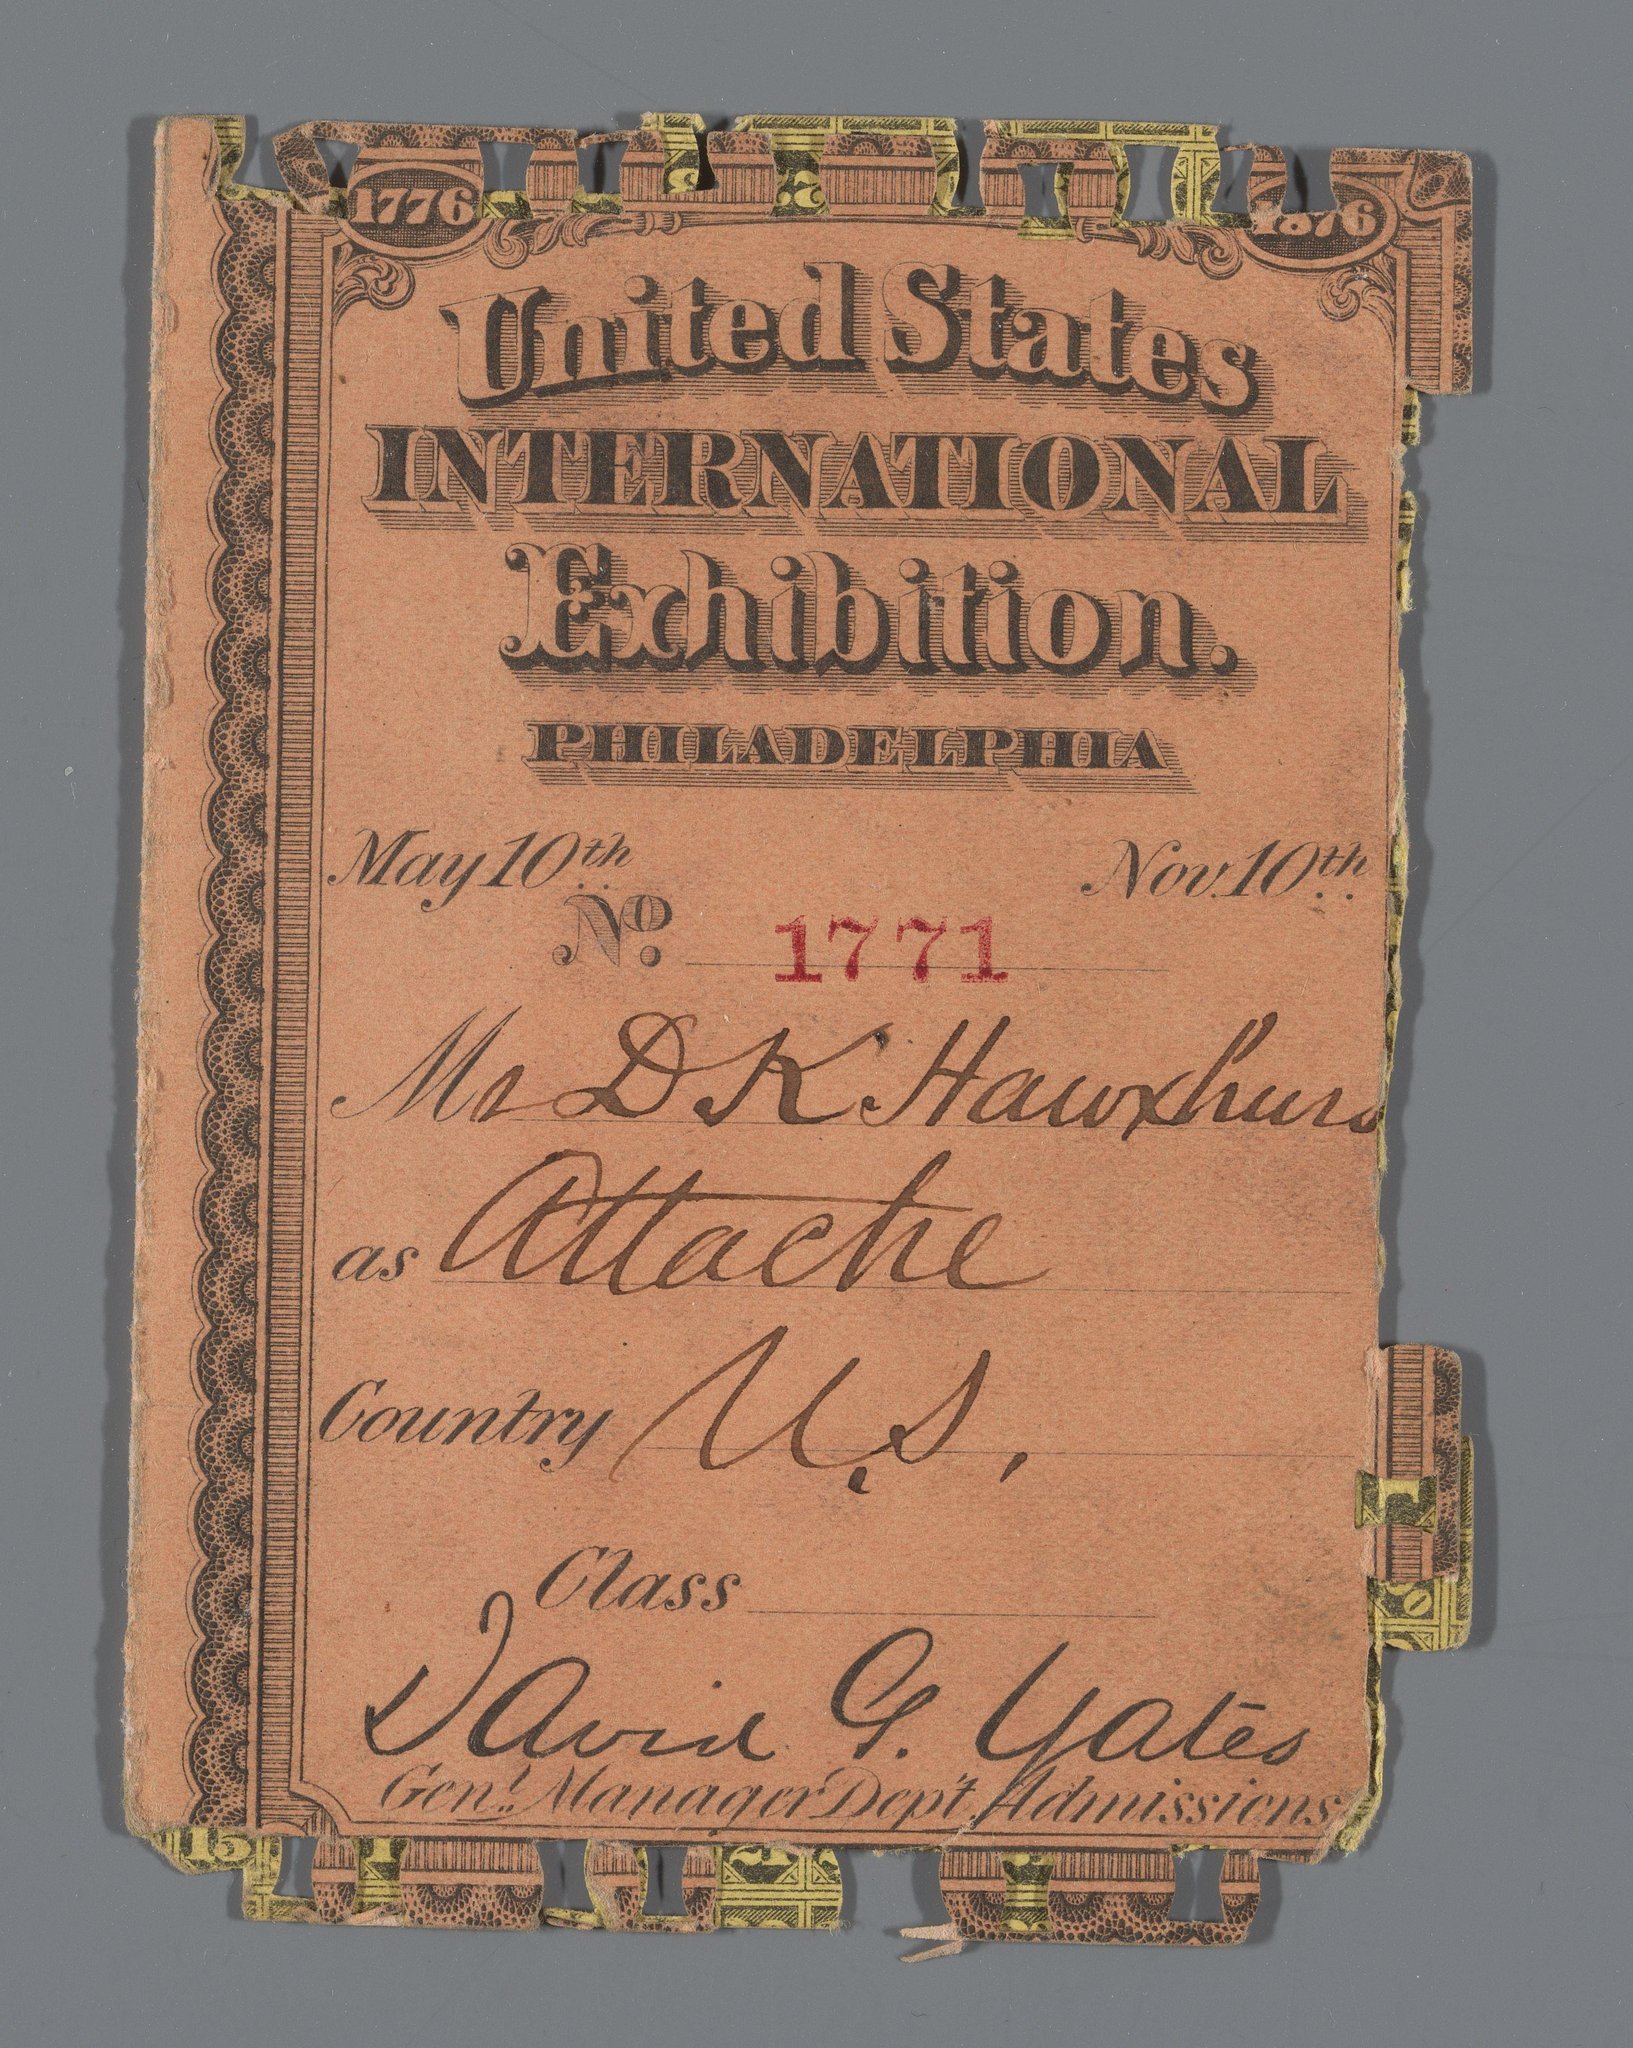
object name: admission ticket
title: Portret van D.K. Hawxhurst, attaché, op dagkaart van de Philadelphia International Exhibition 1876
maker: Anonymous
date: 1876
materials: ink, paper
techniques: albumen print, letterpress printing, pen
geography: philadelphia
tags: adult man, historical persons, centennial exhibition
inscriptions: inscription: ‘This Ticket/ Only/ Good for One/ Daily Admission./ The Holder/ Will/ Obtain a Pass Check/ On Leaving/ The Grounds to/ Return.’, inscription: ‘United States/ International/ Exhibition./ Philadelphia/ May 10th Nov. 10th/ No. 1771/ Mr D.K. Hawxhurst/ as Attache/ Country US/ Class/ David G. Yates/ Genl. Manager Dept. Admissions’, check stamp: ‘International Exhibition Philada May 10th to November 10th/ 1876’